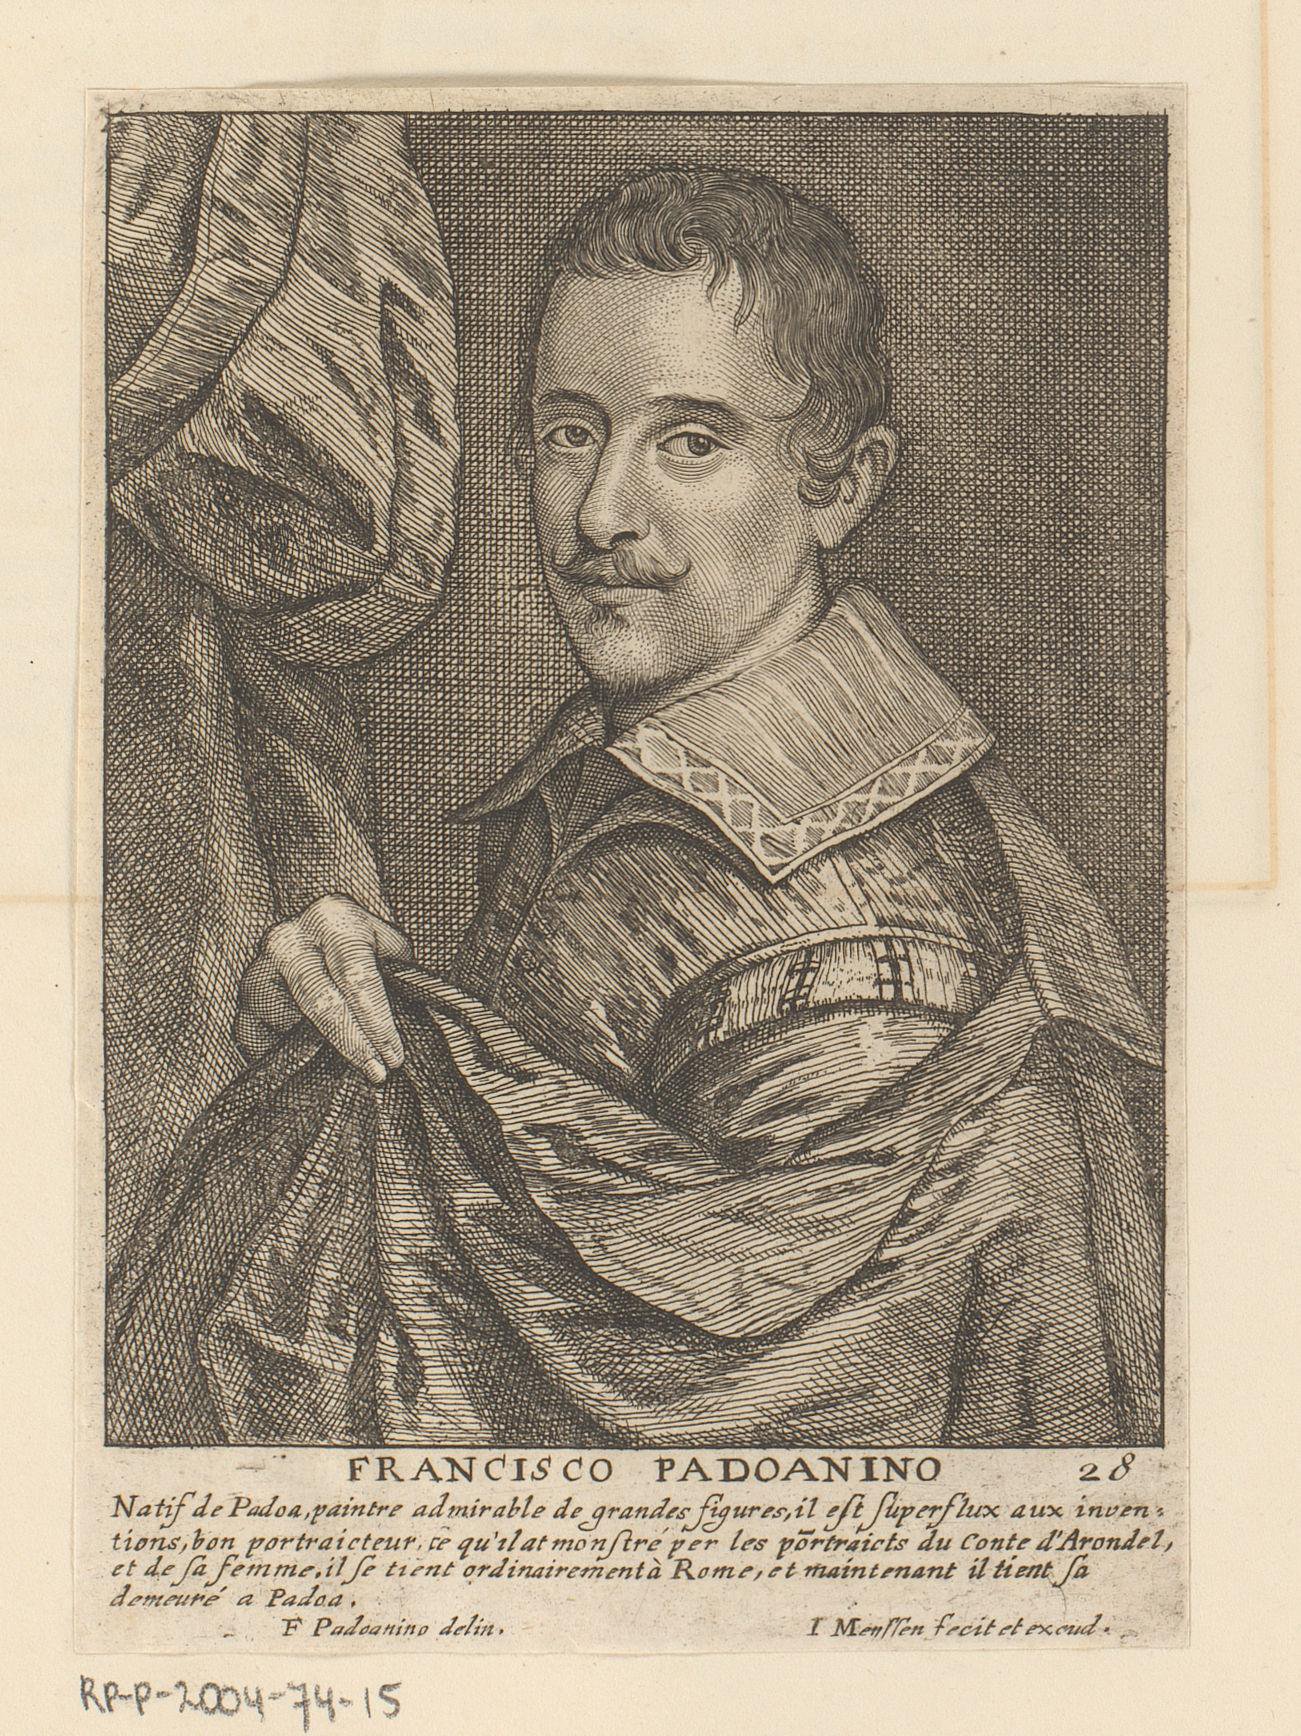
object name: book illustration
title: Portret van Francesco Padovanino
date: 1649-1662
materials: paper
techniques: engraving, etching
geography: antwerp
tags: painter, draughtsman, francesco padovanino, historical persons, portrait, self-portrait of painter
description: Prent uit: Meyssens, Joannes. Image de divers hommes desprit sublime qui par leur art et science deburovent vivre eternellement et des quels la louange et renommée faict estonner le monde. 2 dln. Antwerpen: Joannes Meyssens, 1649, dl. 1, p. 55. De samensteller heeft deze prent in het album geplakt als illustratie bij: Pilkington, Matthew en Johann Heinrich Füssli. A dictionary of painters, from the revival of the art to the present period. 4 dln. Londen: John Crowder, 1805, dl. 3, p. 377.